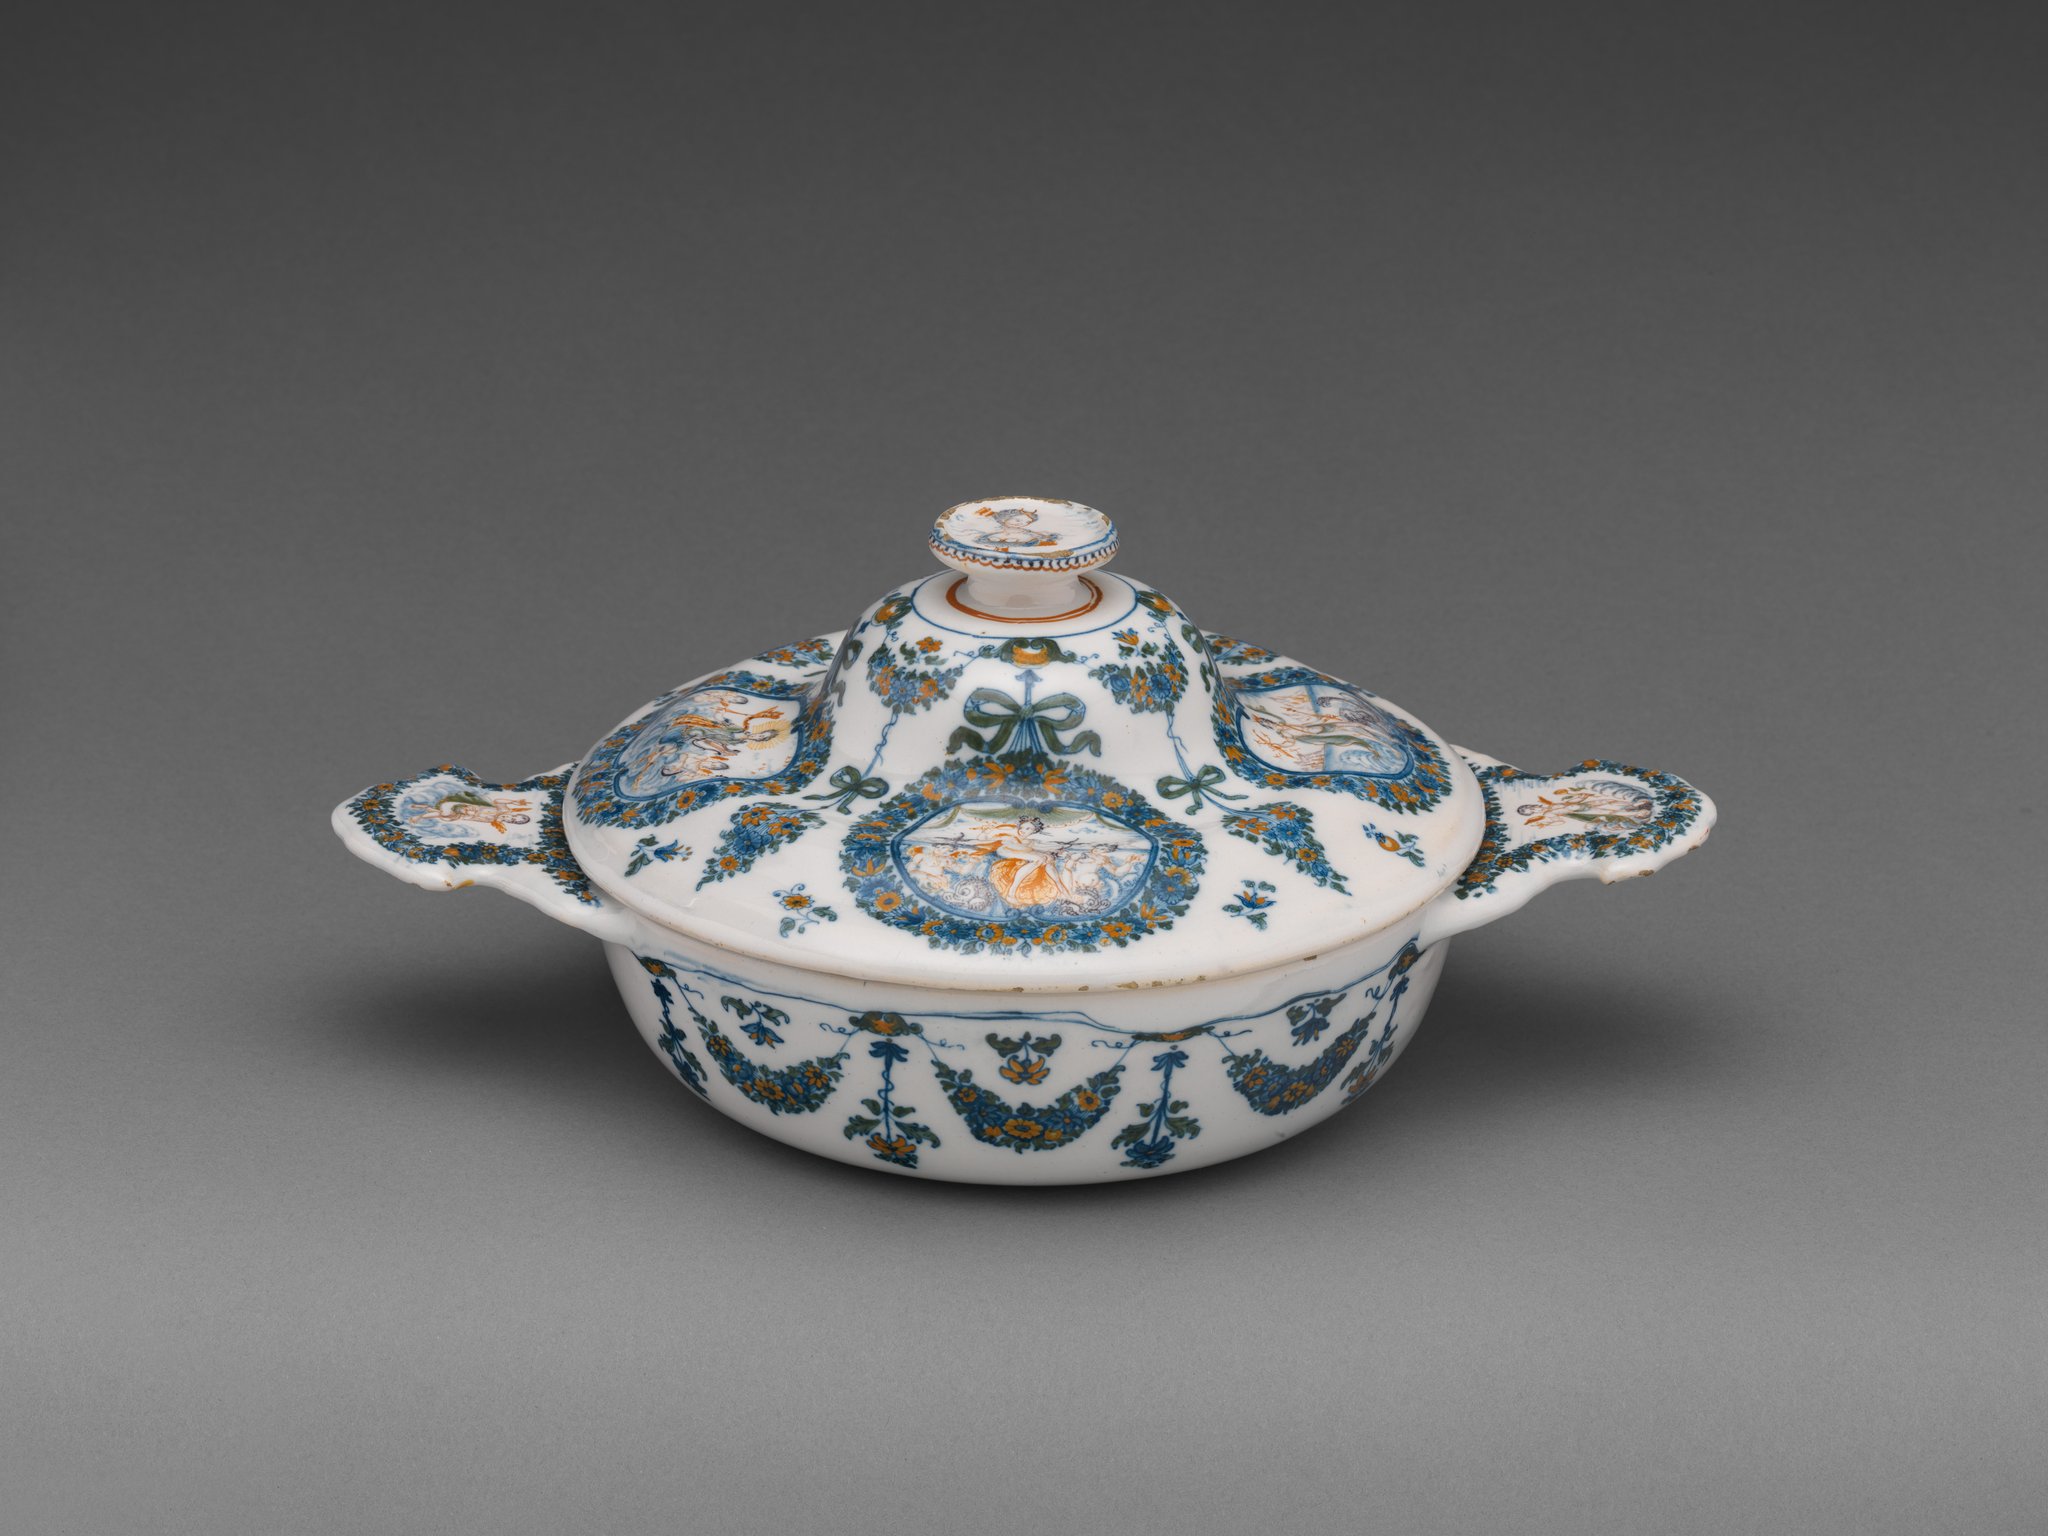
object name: dish with cover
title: Dish with cover (Écuelle)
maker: olérys factory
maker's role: manufactory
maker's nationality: french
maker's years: 1738-1838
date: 1745-1750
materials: faience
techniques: glazing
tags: women,flowers